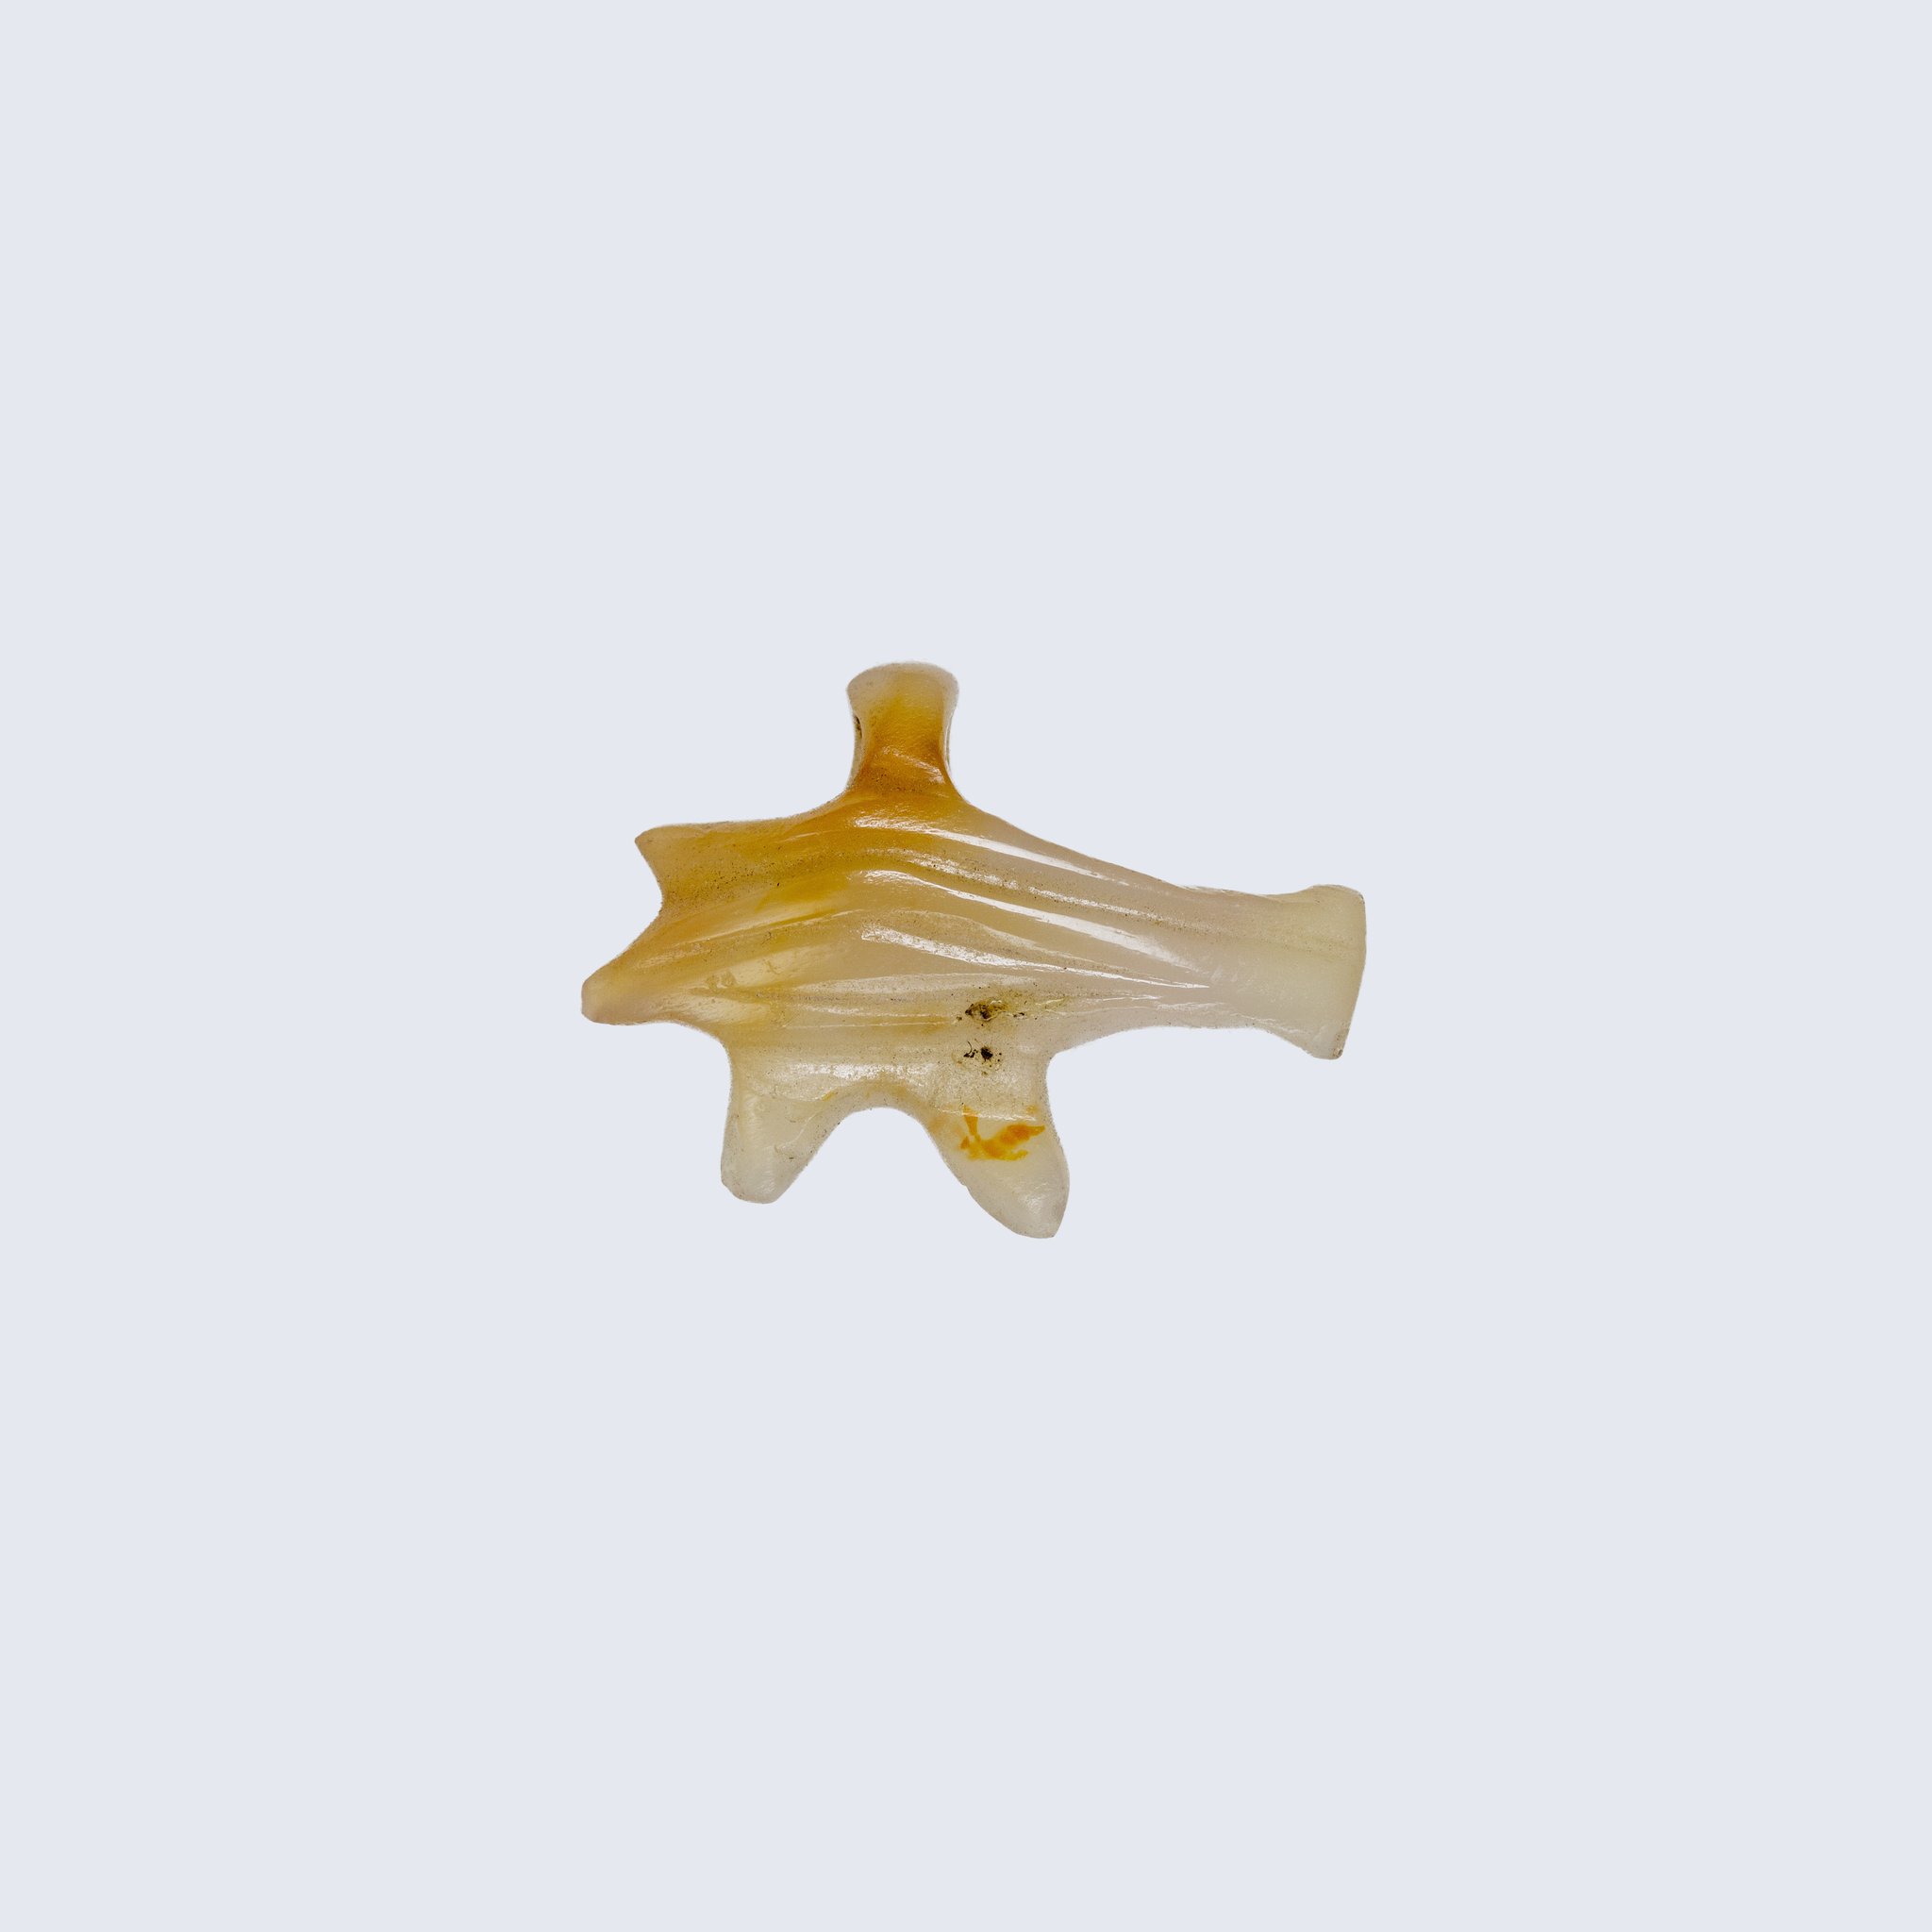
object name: amulet, wedjat eye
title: Wedjat Eye Amulet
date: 2150-1950 BCE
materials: gemstone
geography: southern upper egypt